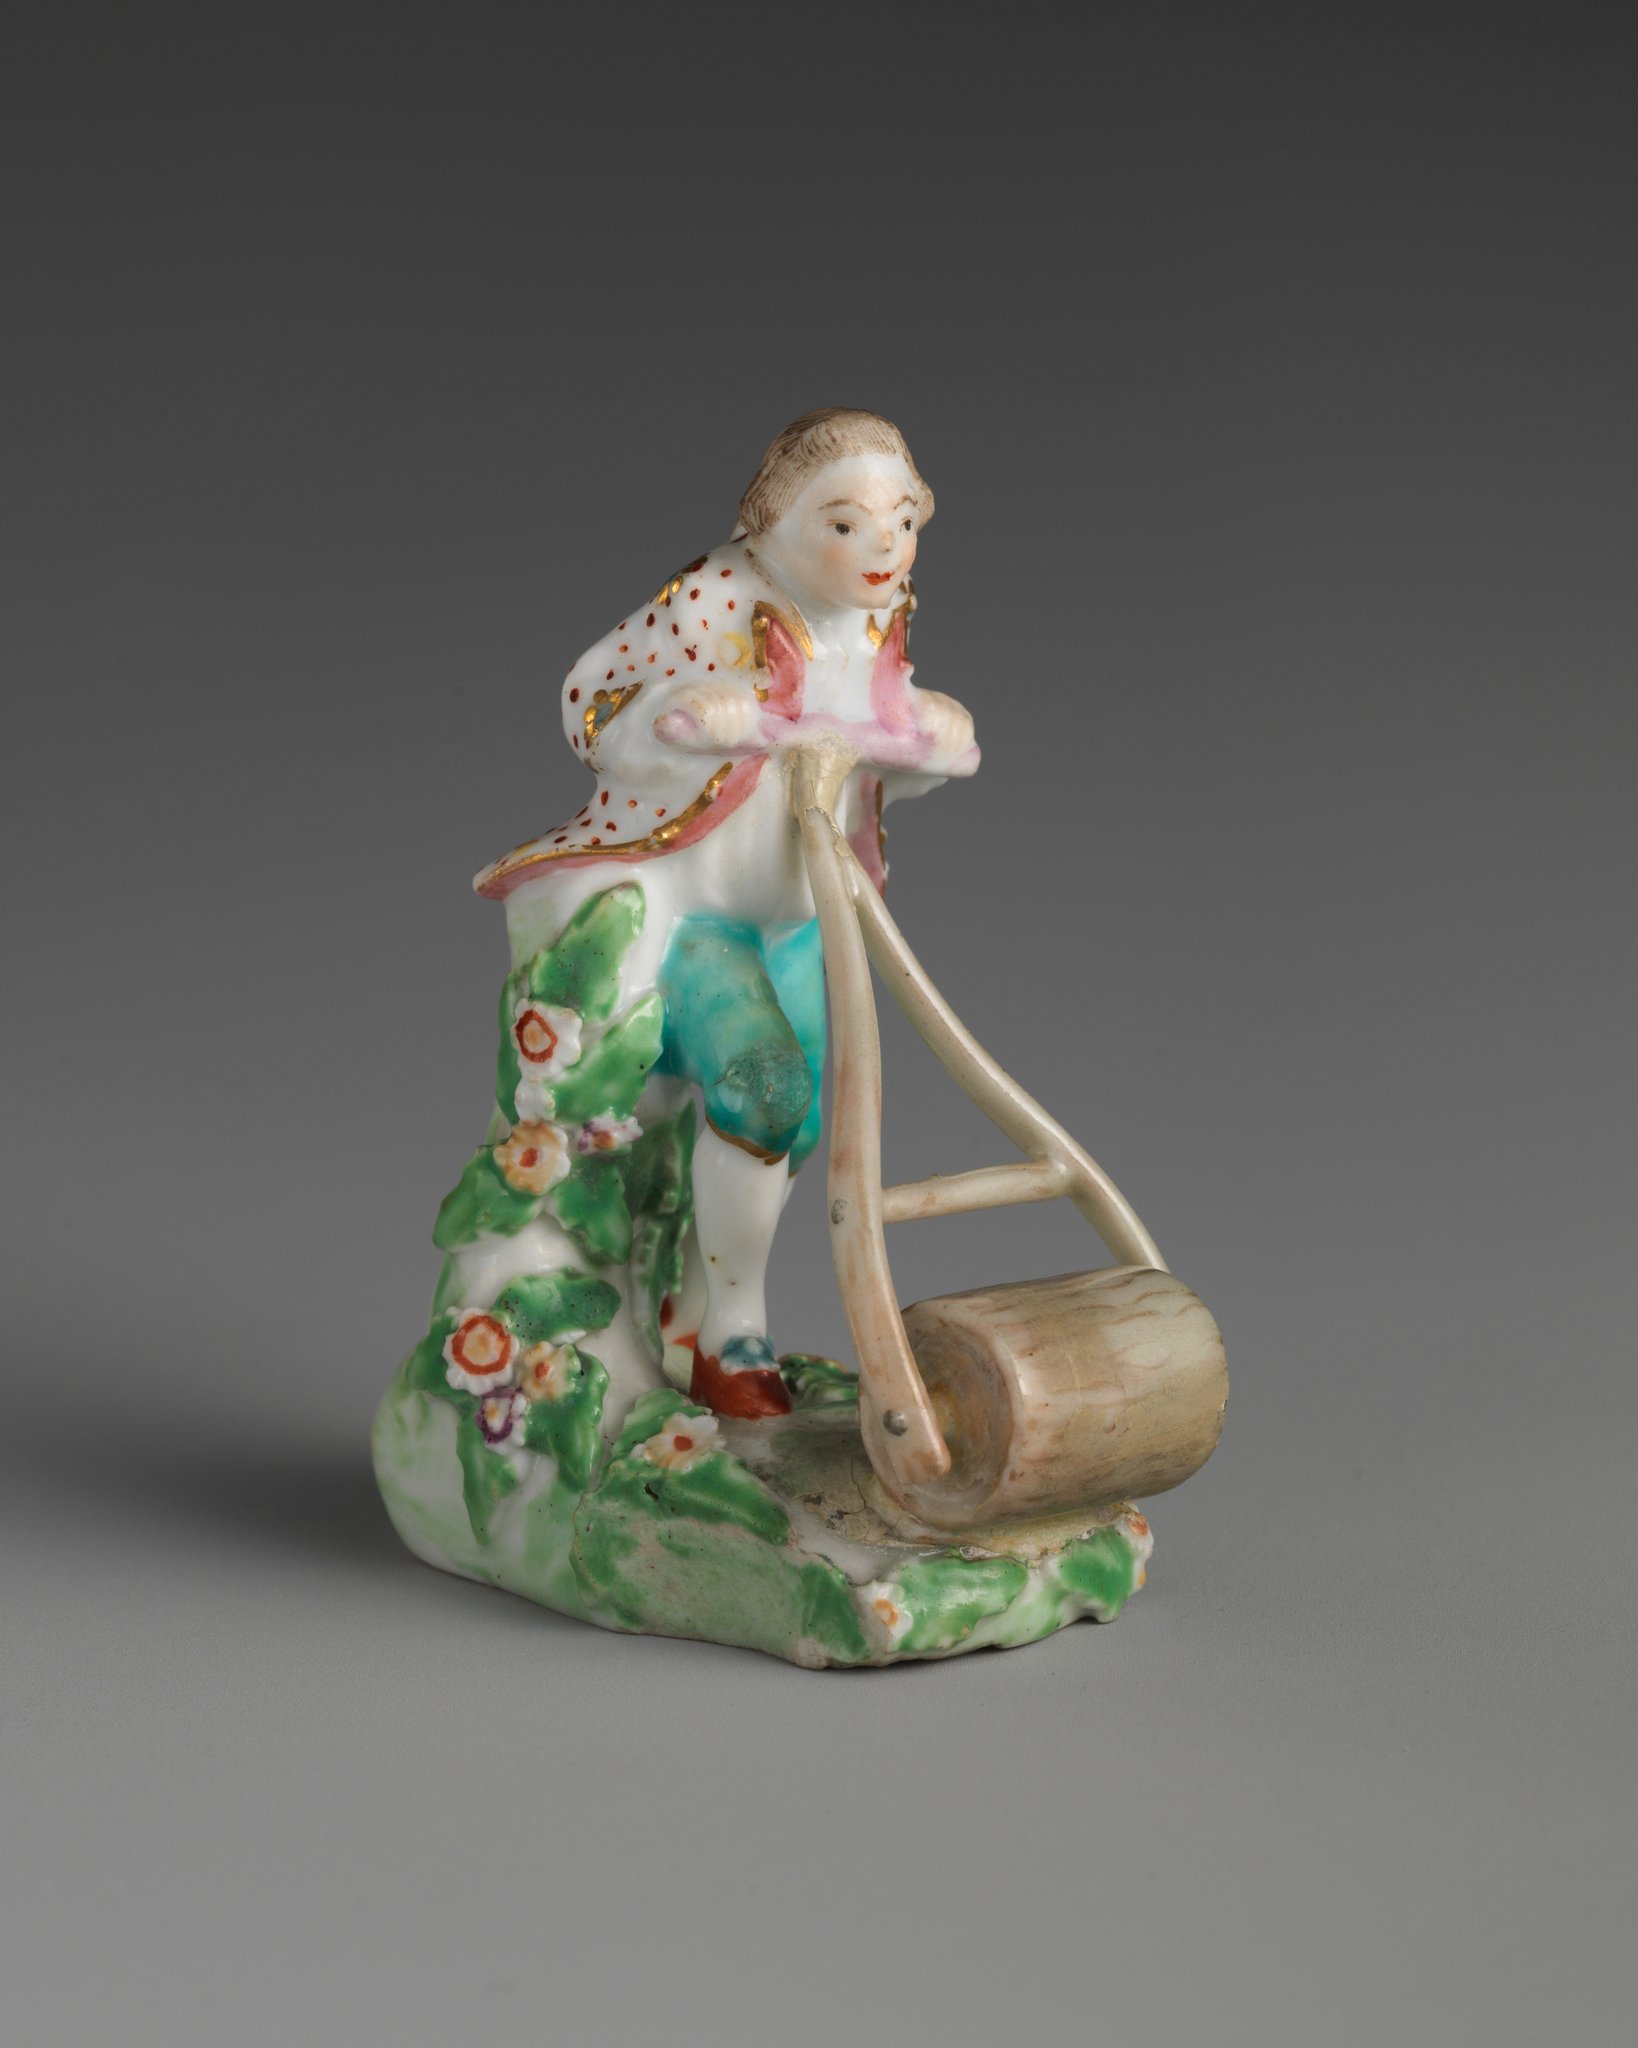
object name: toy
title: Gardener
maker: derby porcelain manufactory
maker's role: factory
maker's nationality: british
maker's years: 1751-1785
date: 1765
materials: soft paste porcelain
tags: men,gardeners